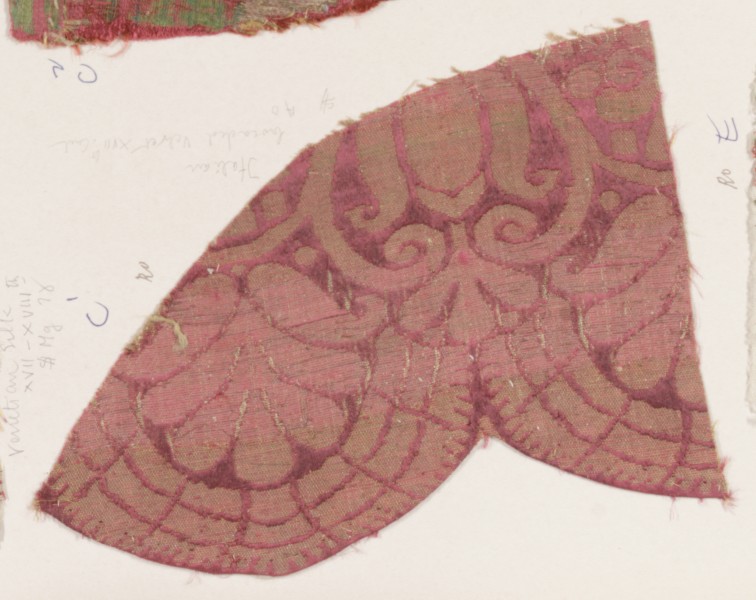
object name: fragment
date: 1501-1700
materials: silk